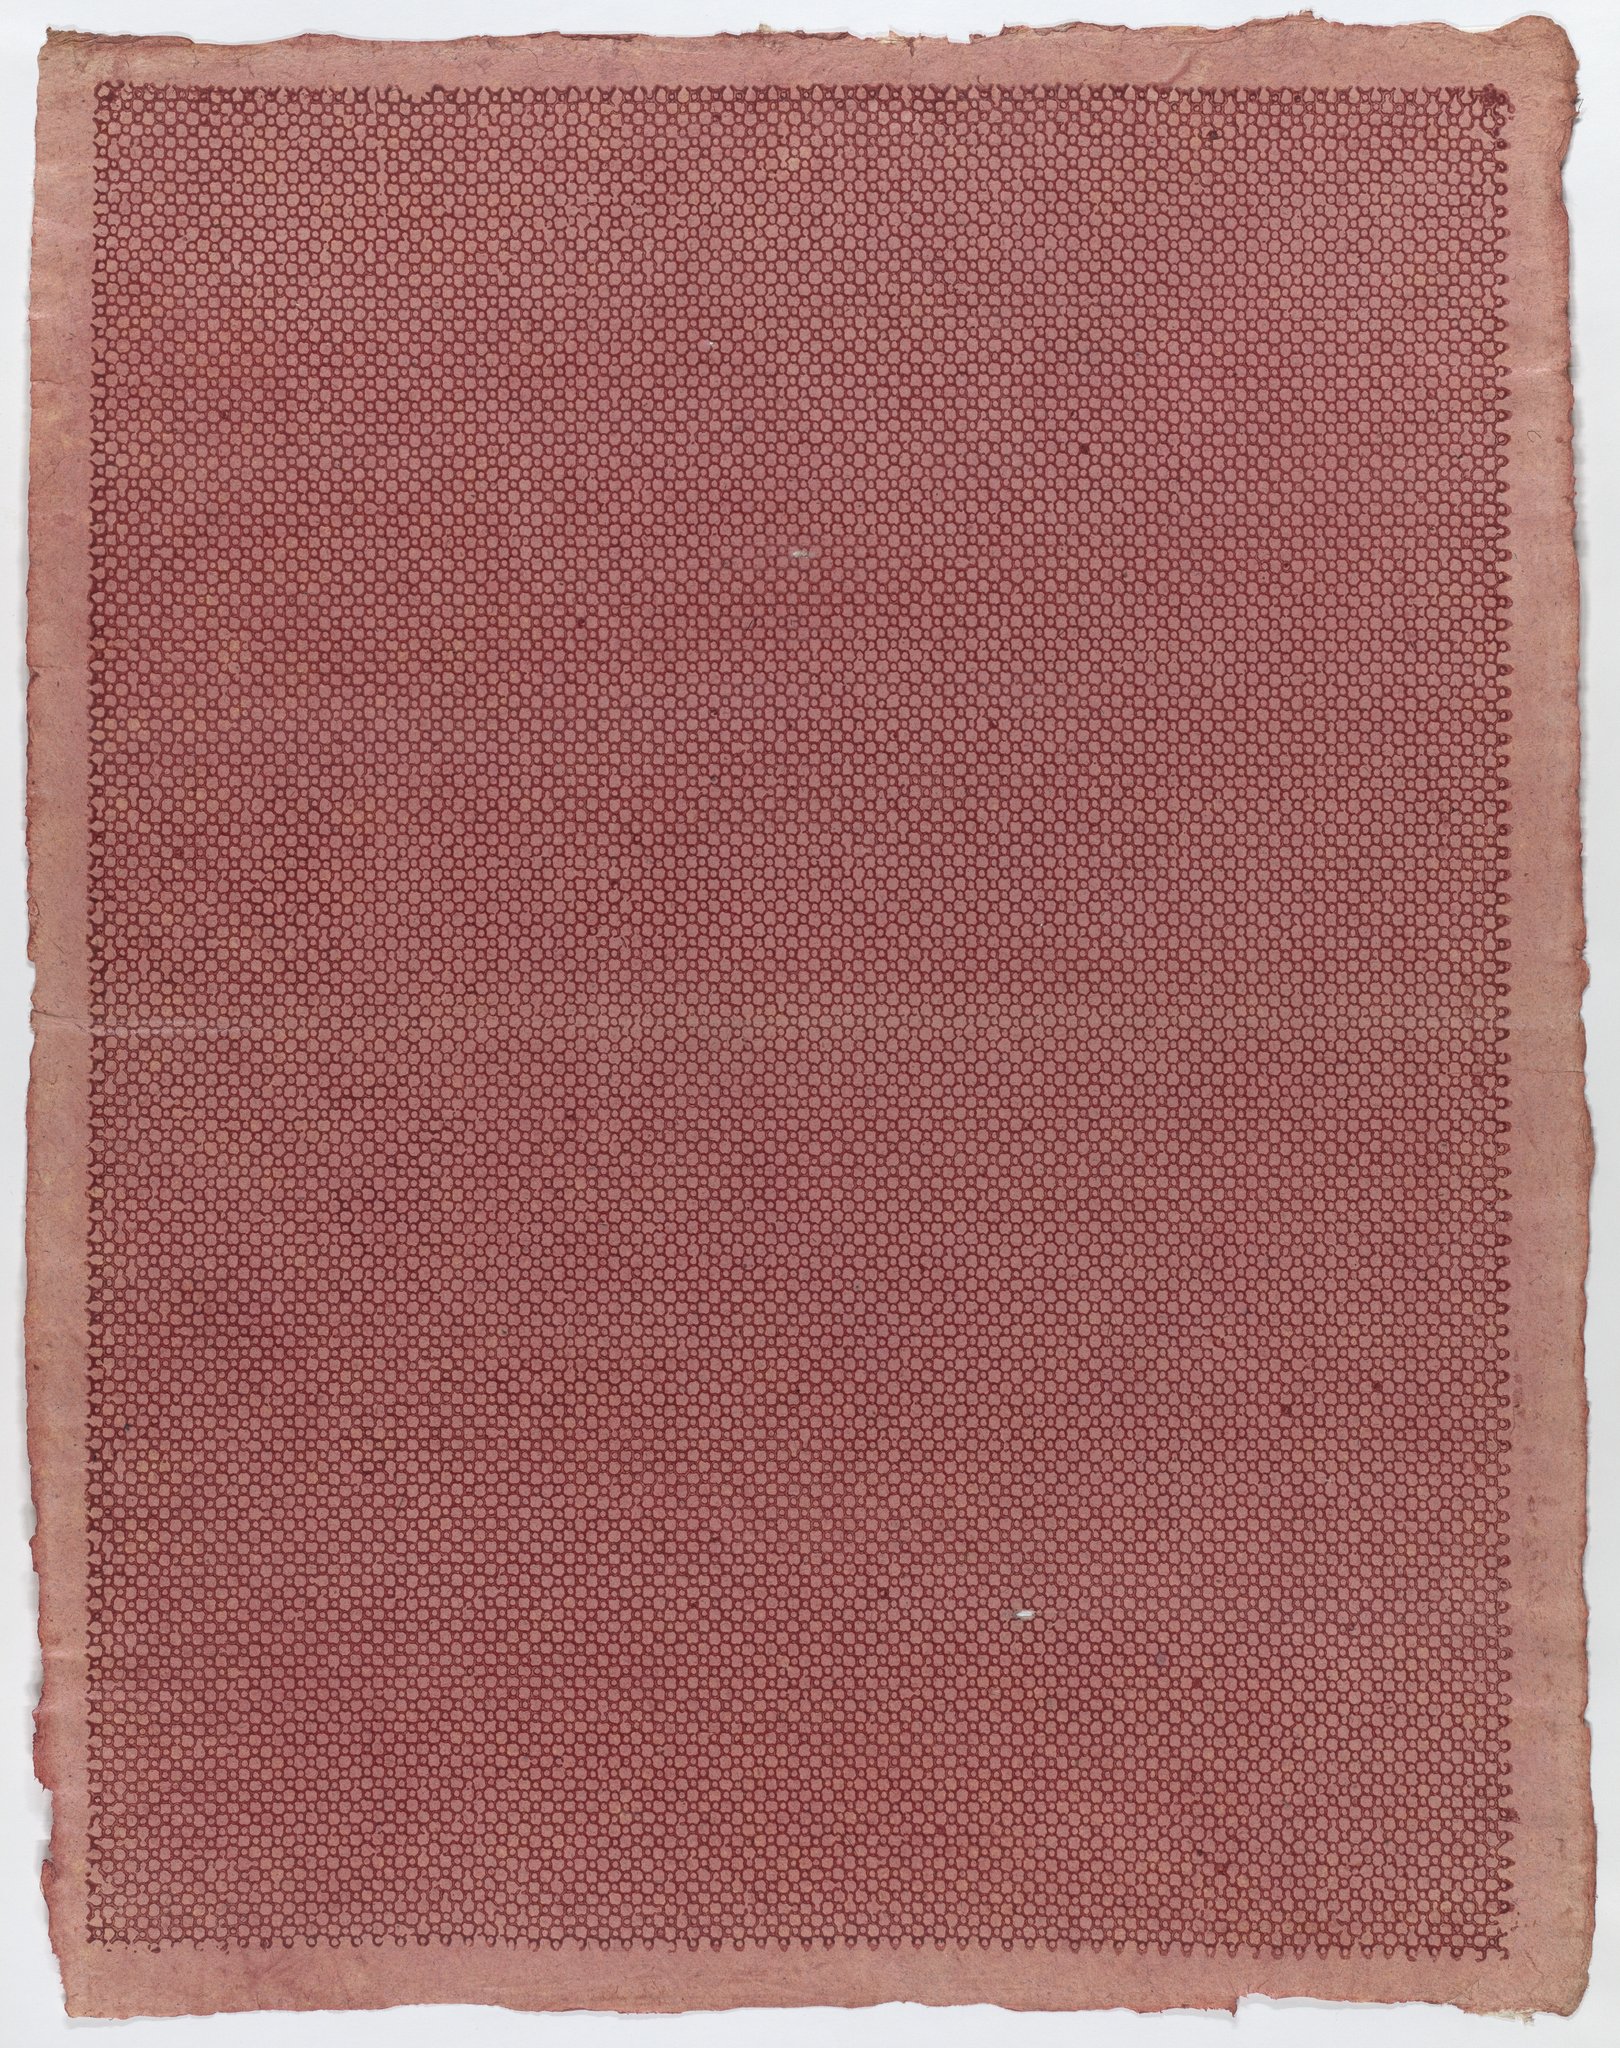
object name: print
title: Sheet with an overall honeycomb pattern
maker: Anonymous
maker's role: artist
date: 1767-1866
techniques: relief print